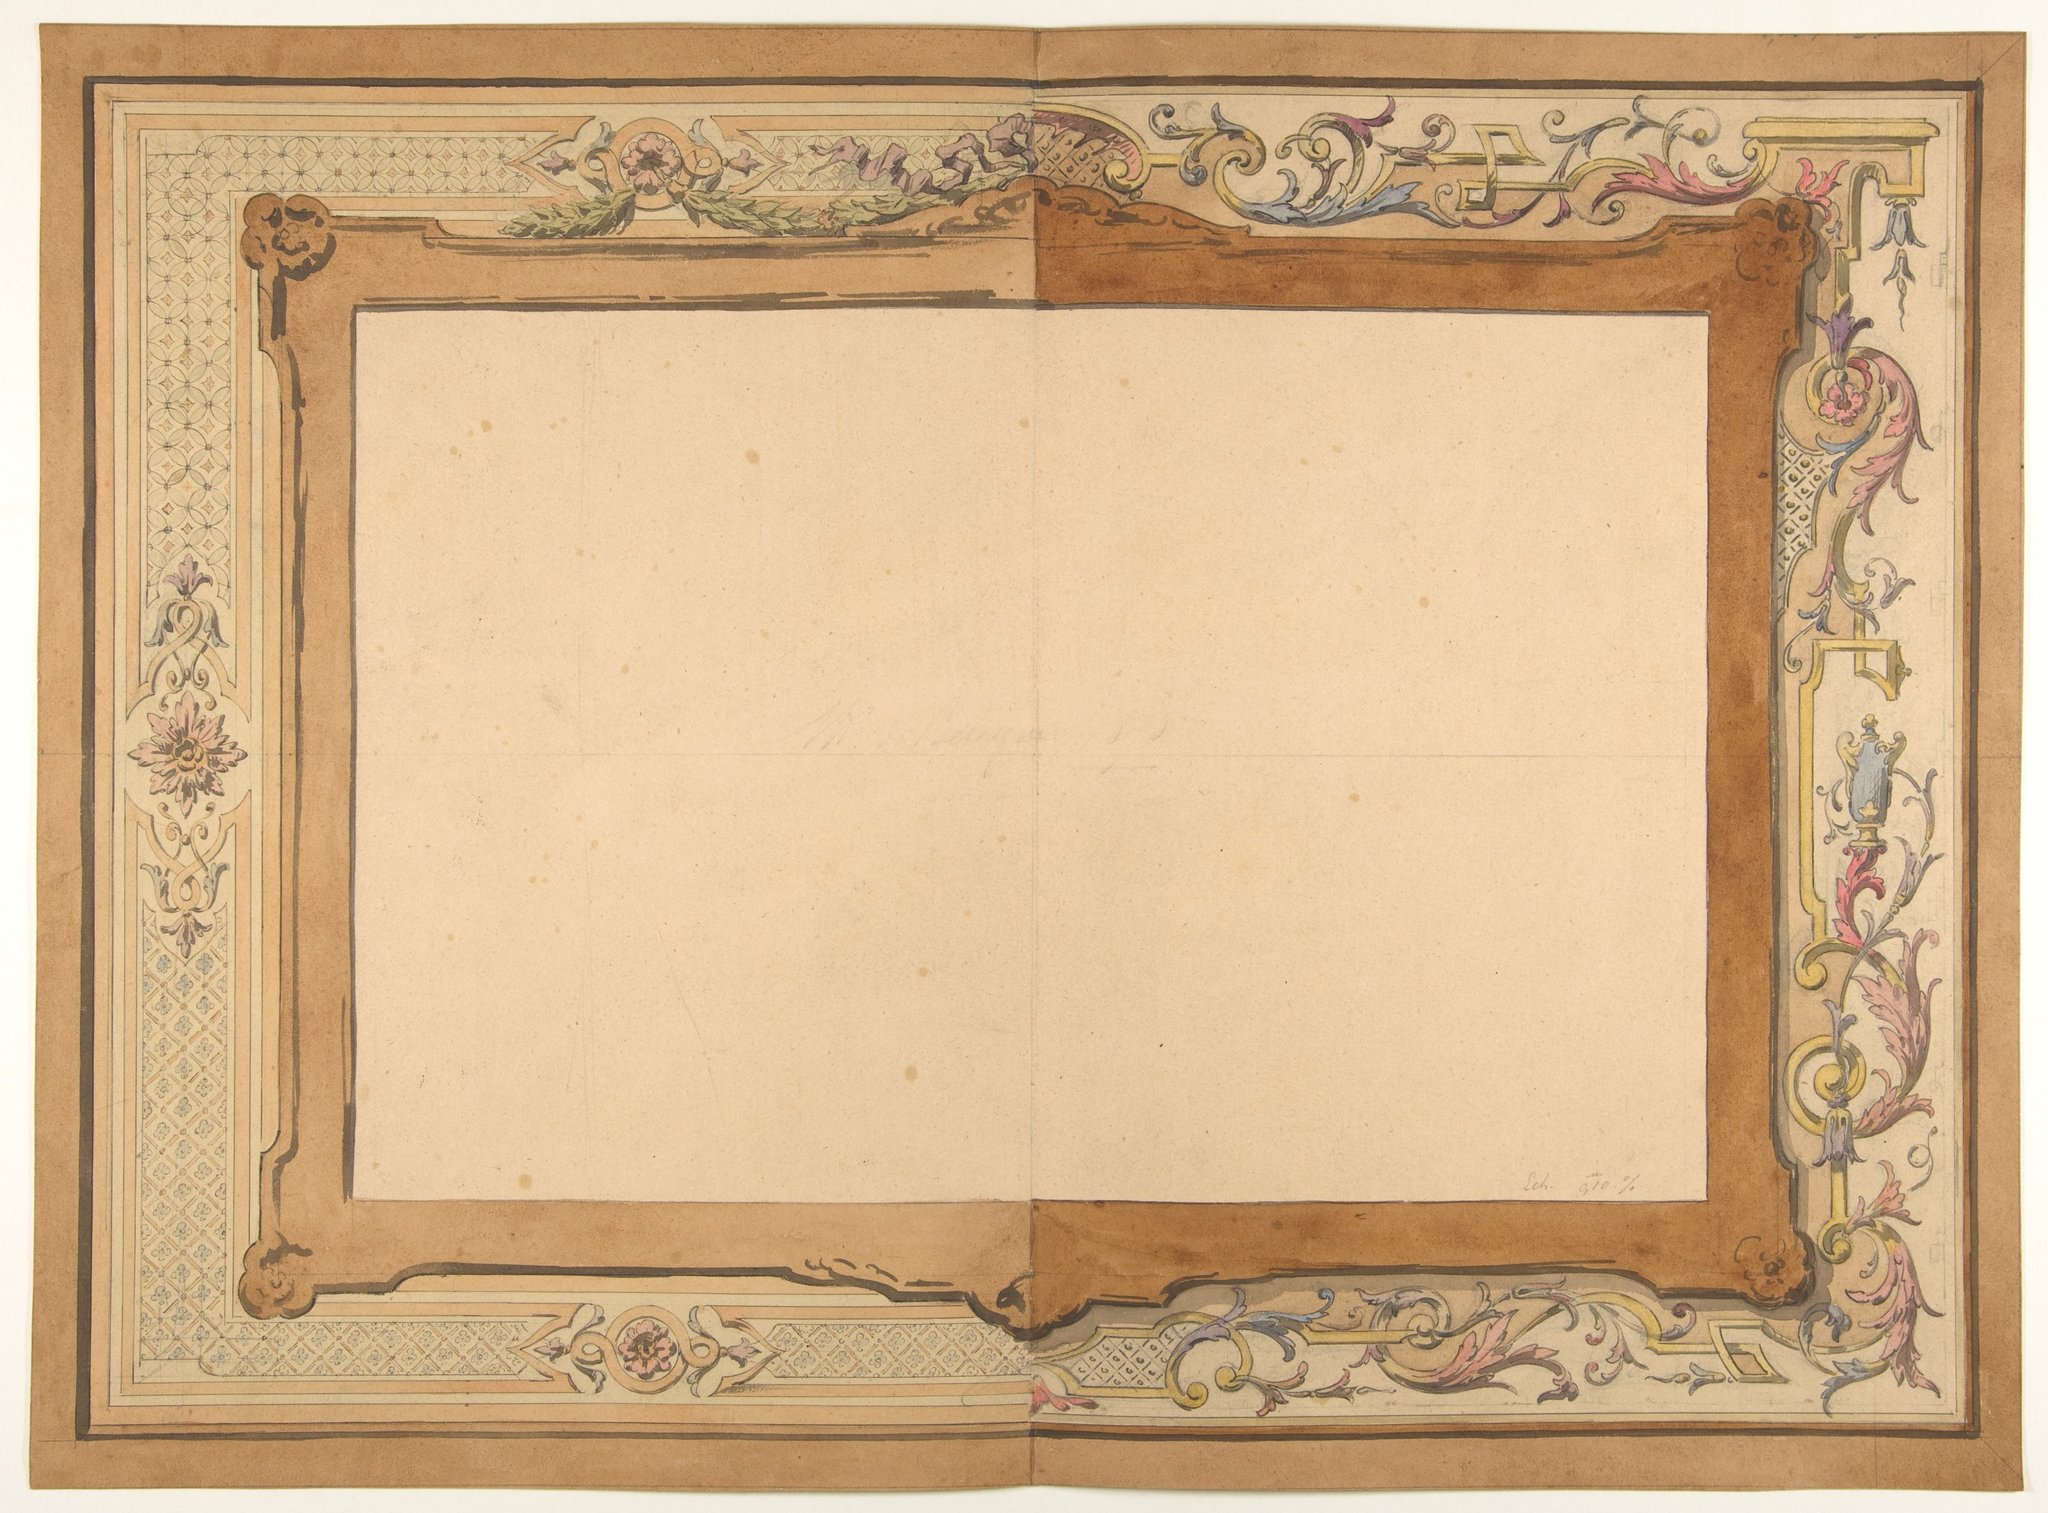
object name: drawing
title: Design for a ceiling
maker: jules-edmond-charles lachaise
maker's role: artist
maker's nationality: french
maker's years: 1897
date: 1851-1900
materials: graphite, watercolor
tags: ceilings